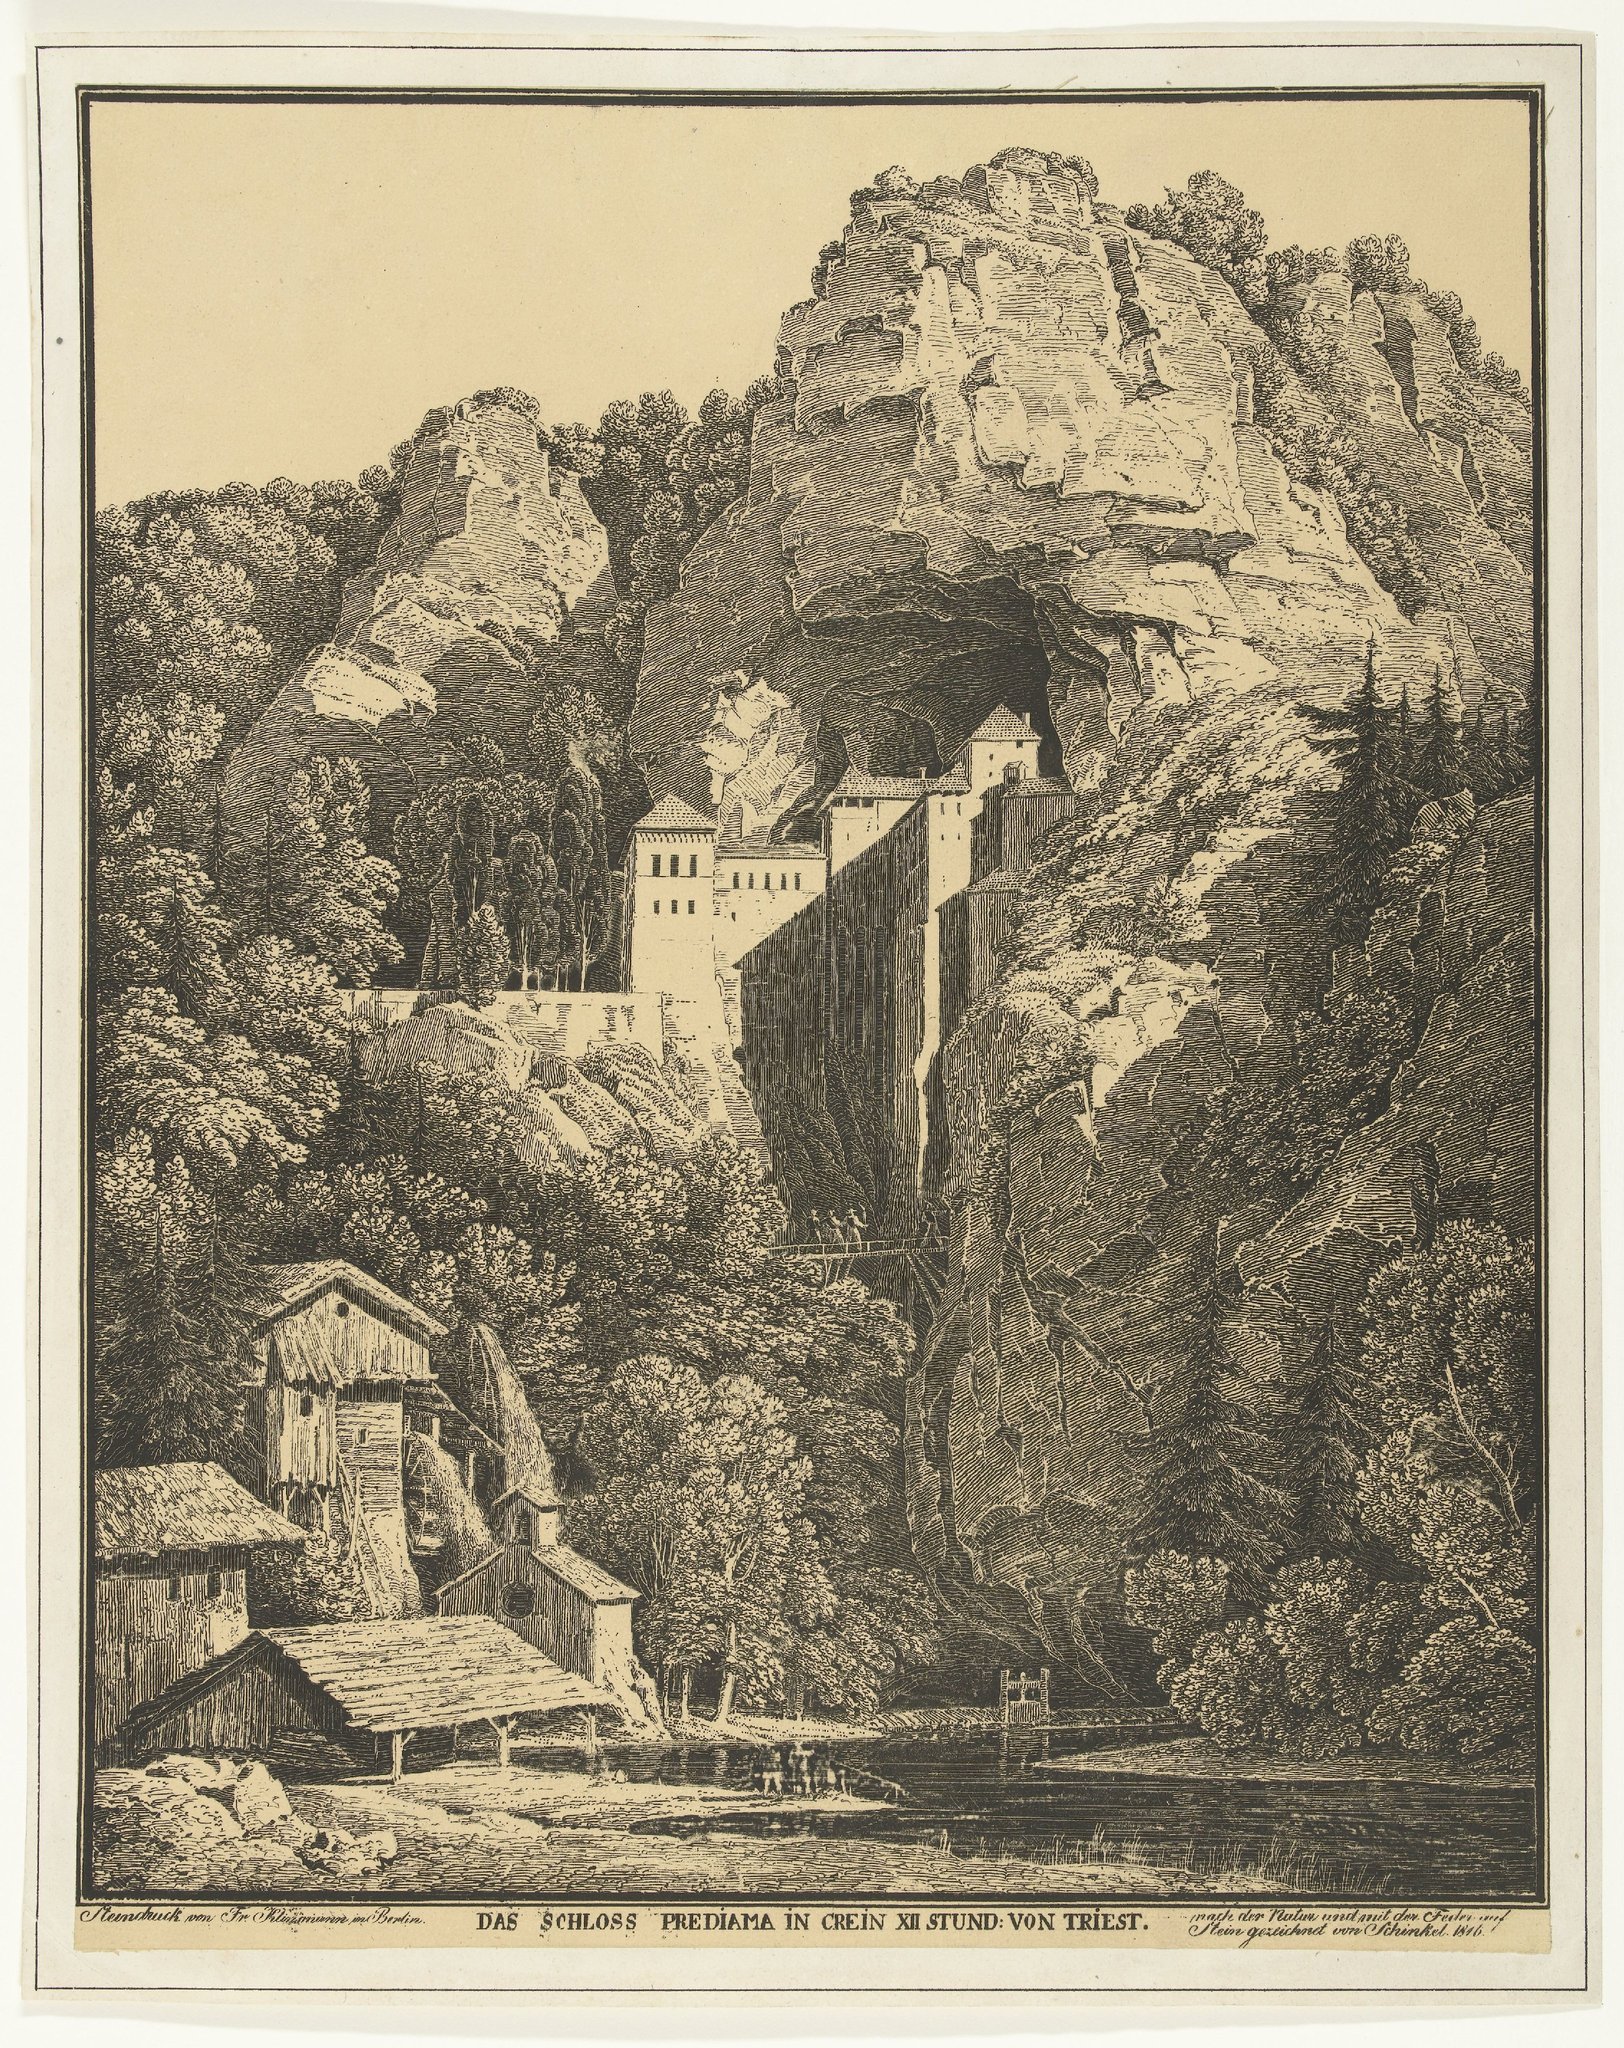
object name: print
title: Das Schloss Prediama in Crein XII Stund von Triest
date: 1816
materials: paper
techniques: lithograph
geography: berlin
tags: castle, rocks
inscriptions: collector's mark: Lugt 2760, collector's mark: Lugt 2228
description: Gezicht op hoge rotsen met een in een spelonk gebouwde burcht. Op de voorgrond een beek, links een watermolen.